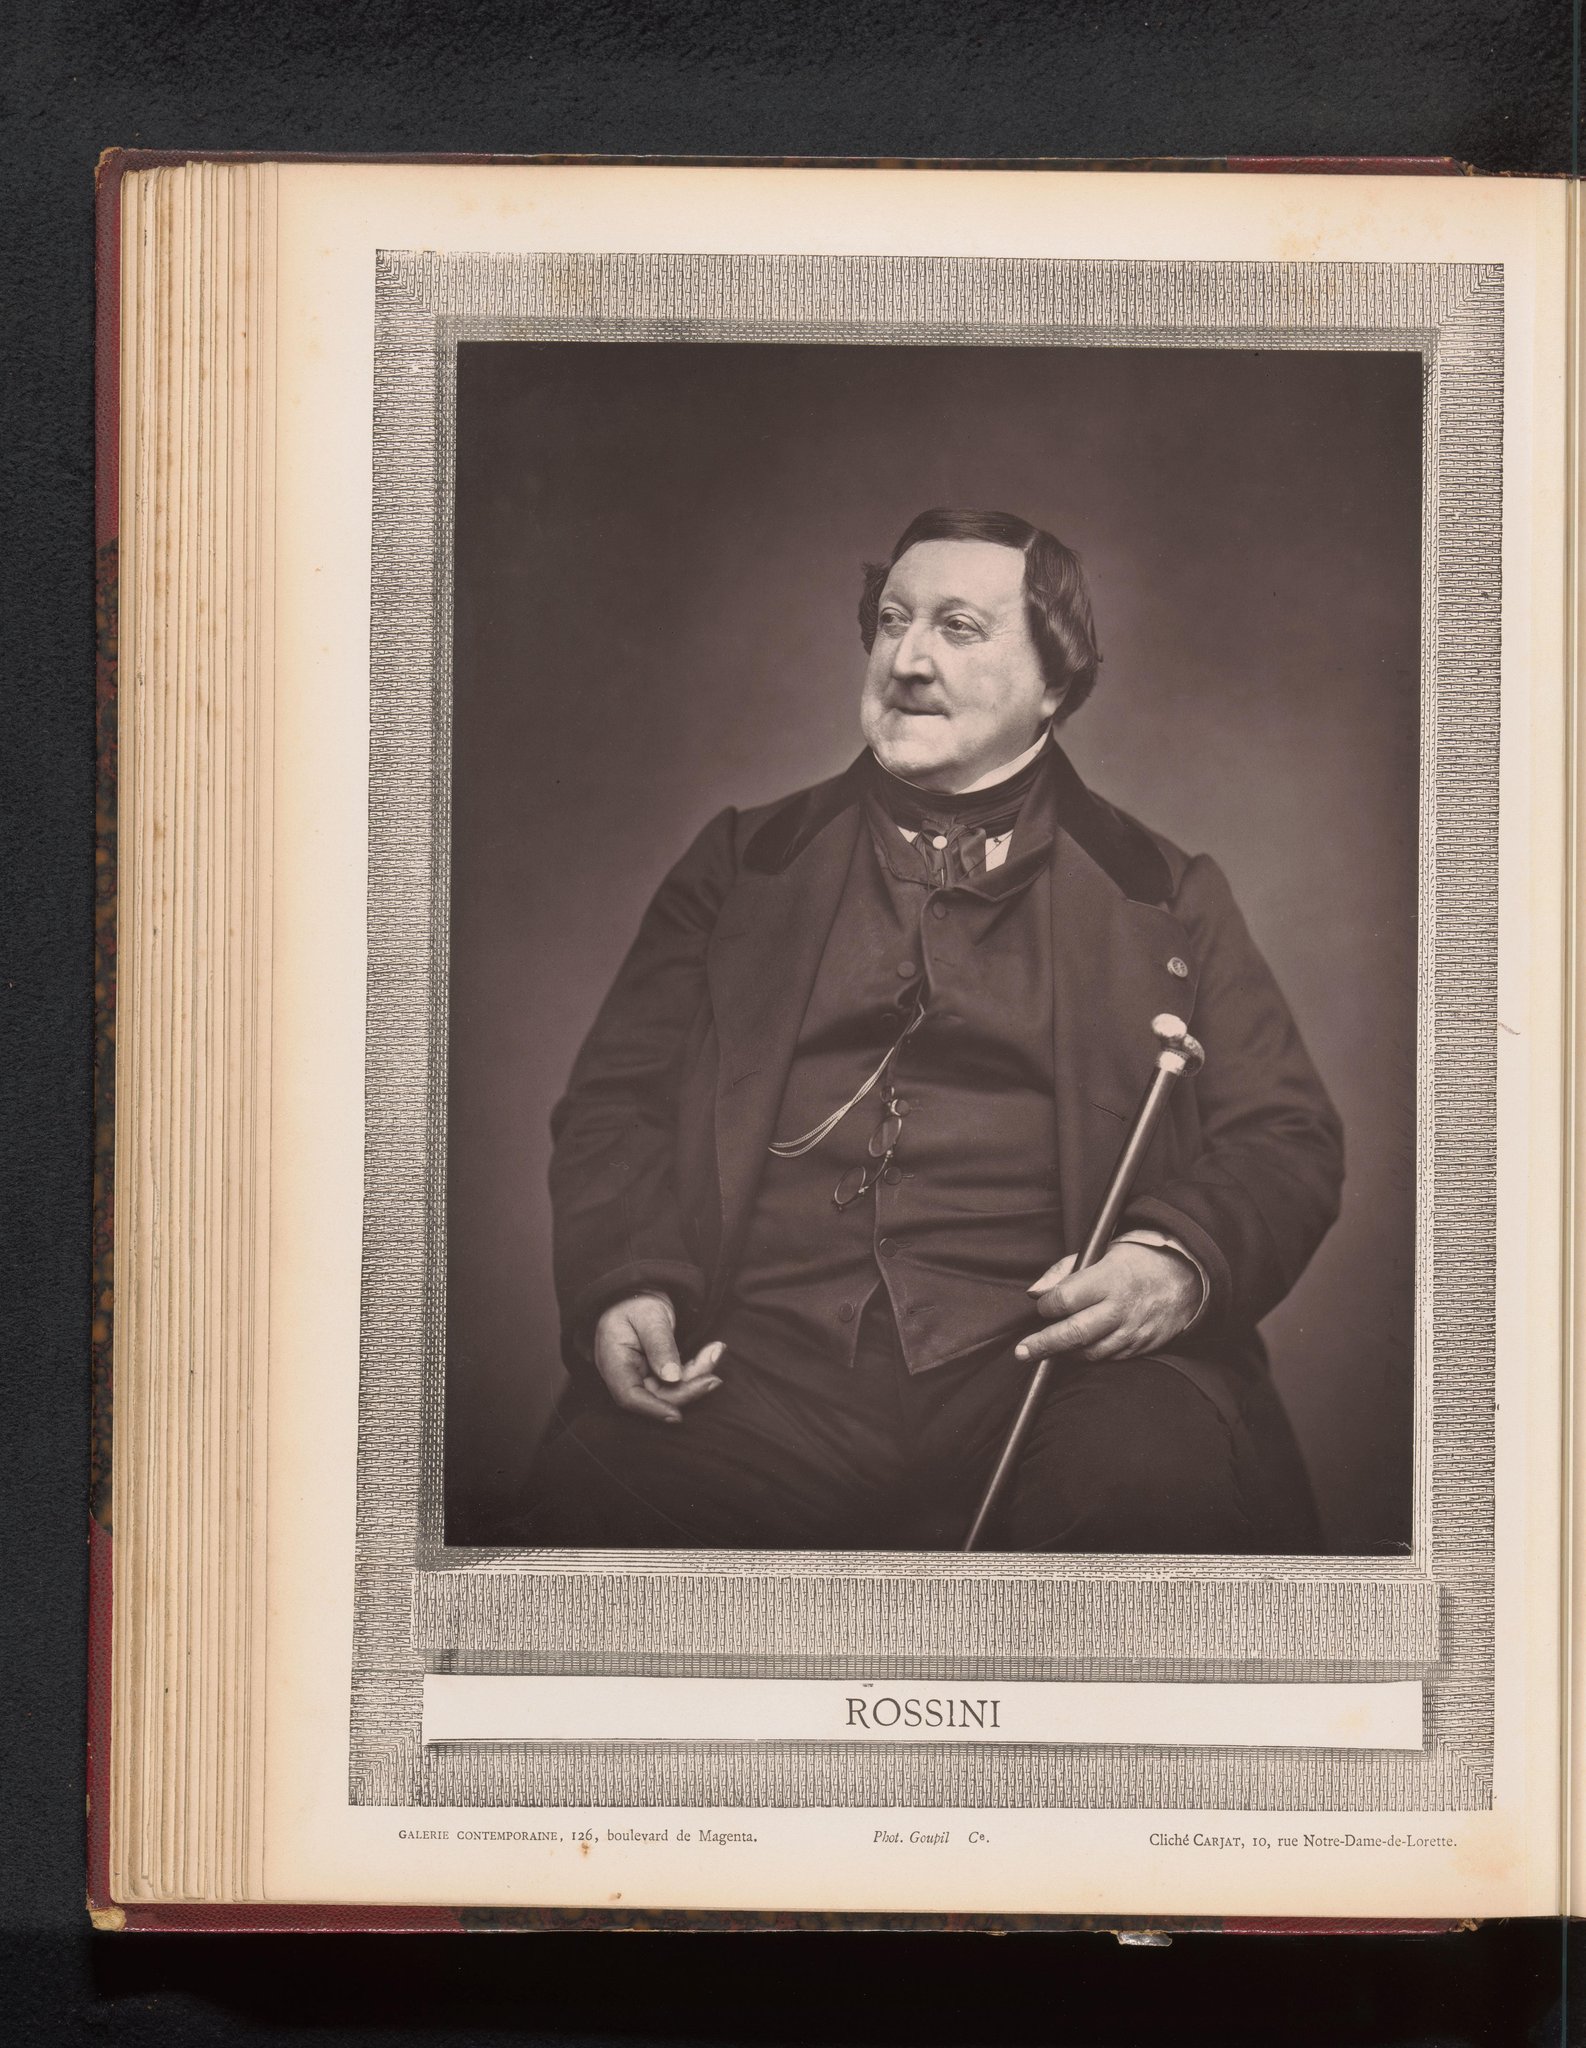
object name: page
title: Portret van Gioachino Rossini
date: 1871-1876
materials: paper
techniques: woodburytype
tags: gioacchino antonio rossini, adult man, historical persons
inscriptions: inscription: ‘Galerie Contemporaine, 126 boulevard de Magenta.’